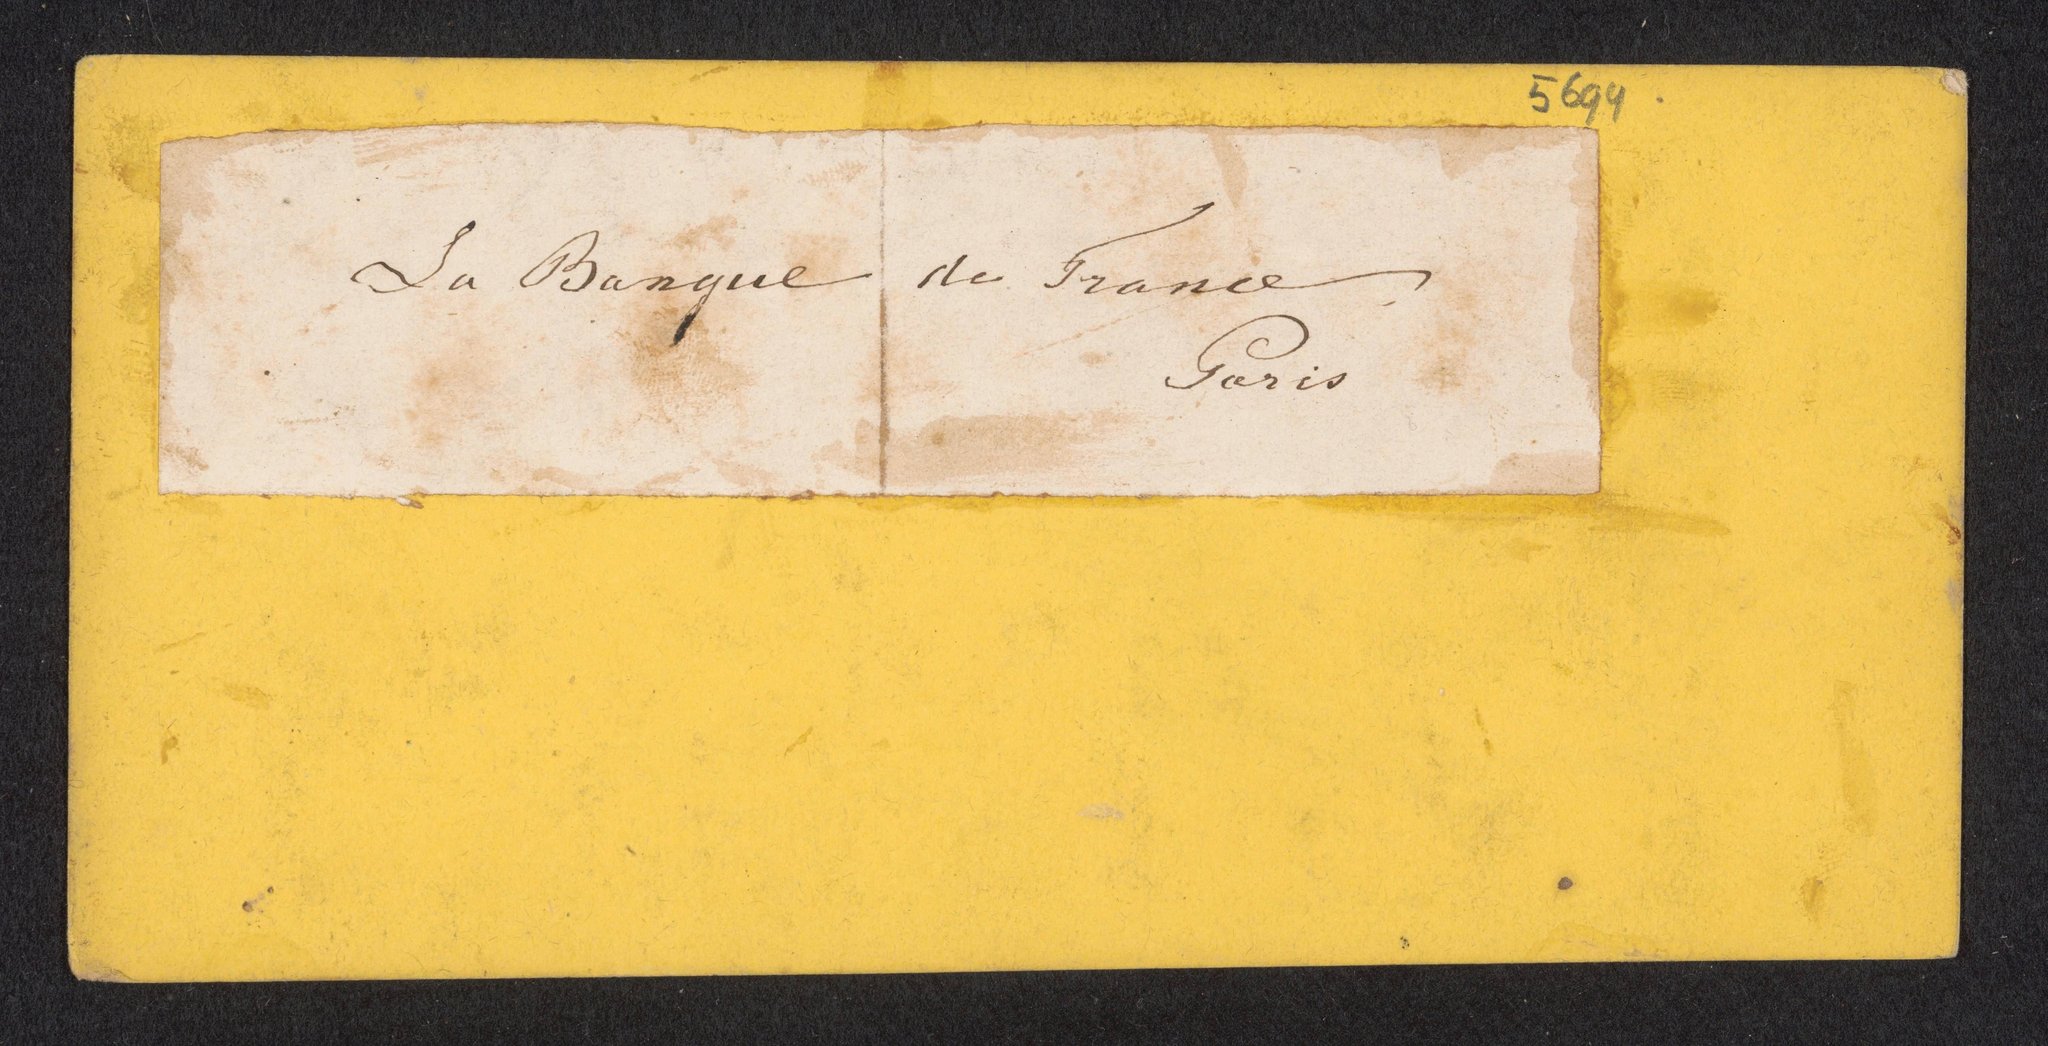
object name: stereograph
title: Gezicht op een poort van vermoedelijk een bankgebouw in Parijs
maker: Anonymous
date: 1850-1880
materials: cardboard, photographic support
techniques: albumen print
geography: paris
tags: gate, entrance, bank, paris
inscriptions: inscription: ‘La Banque de France Paris’